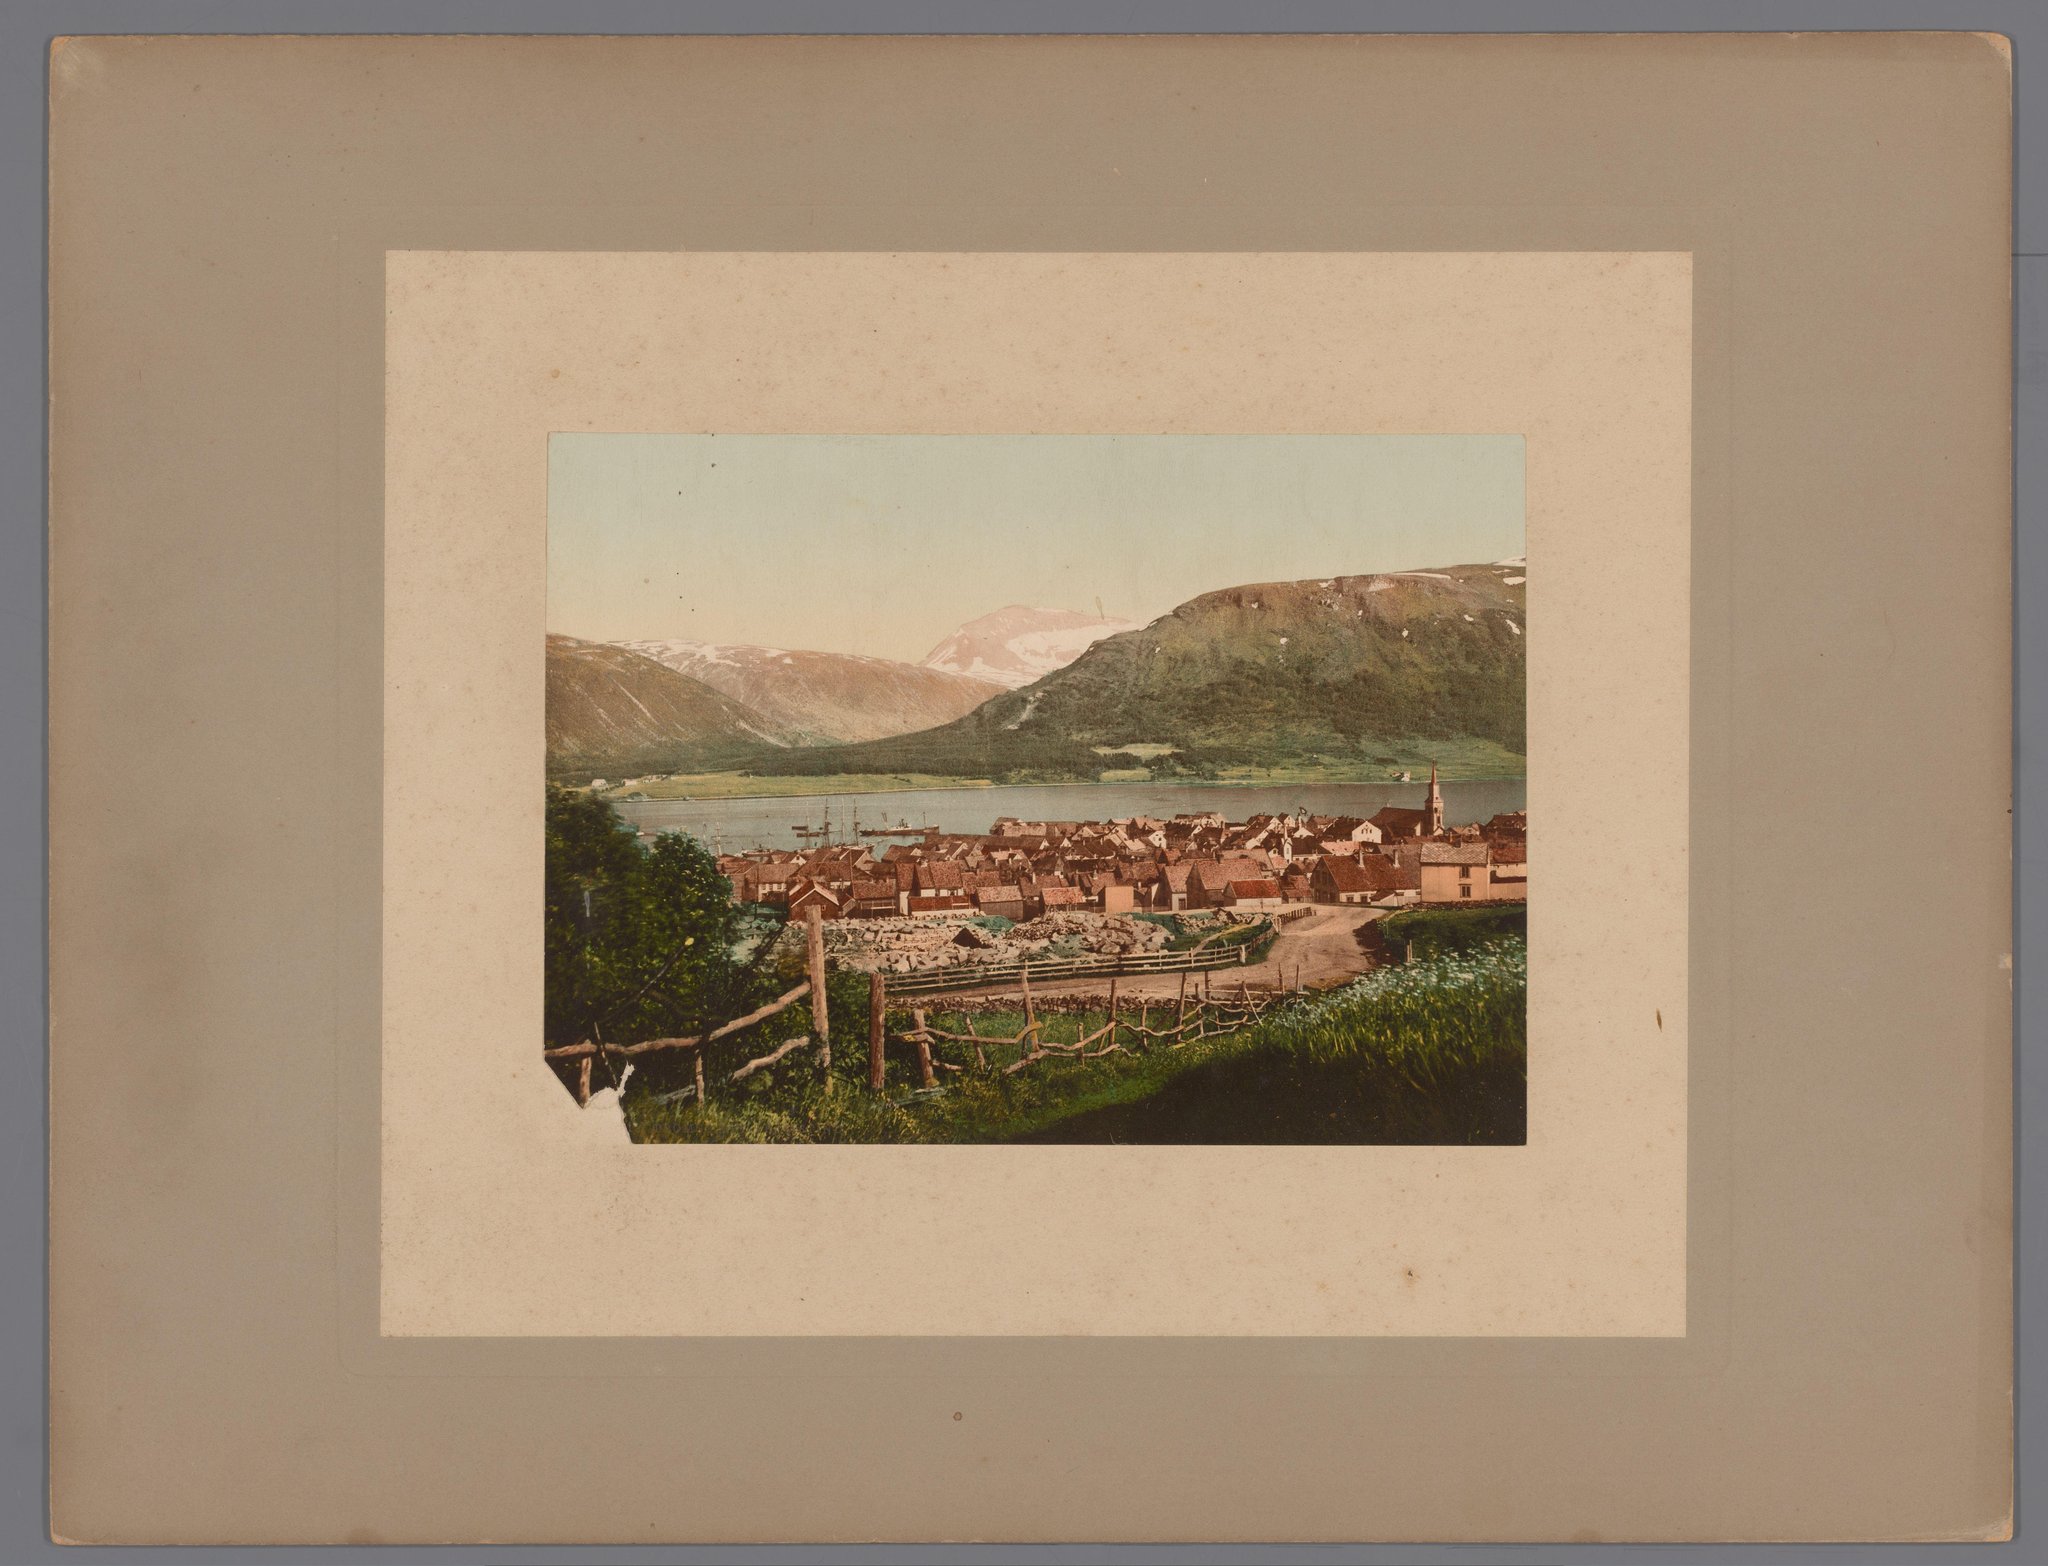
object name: photomechanical print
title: Dorpsgezicht in Noorwegen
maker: Anonymous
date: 1860-1900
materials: cardboard, paper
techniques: albumen print, lithograph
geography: norway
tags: city-view in general; 'veduta', norway